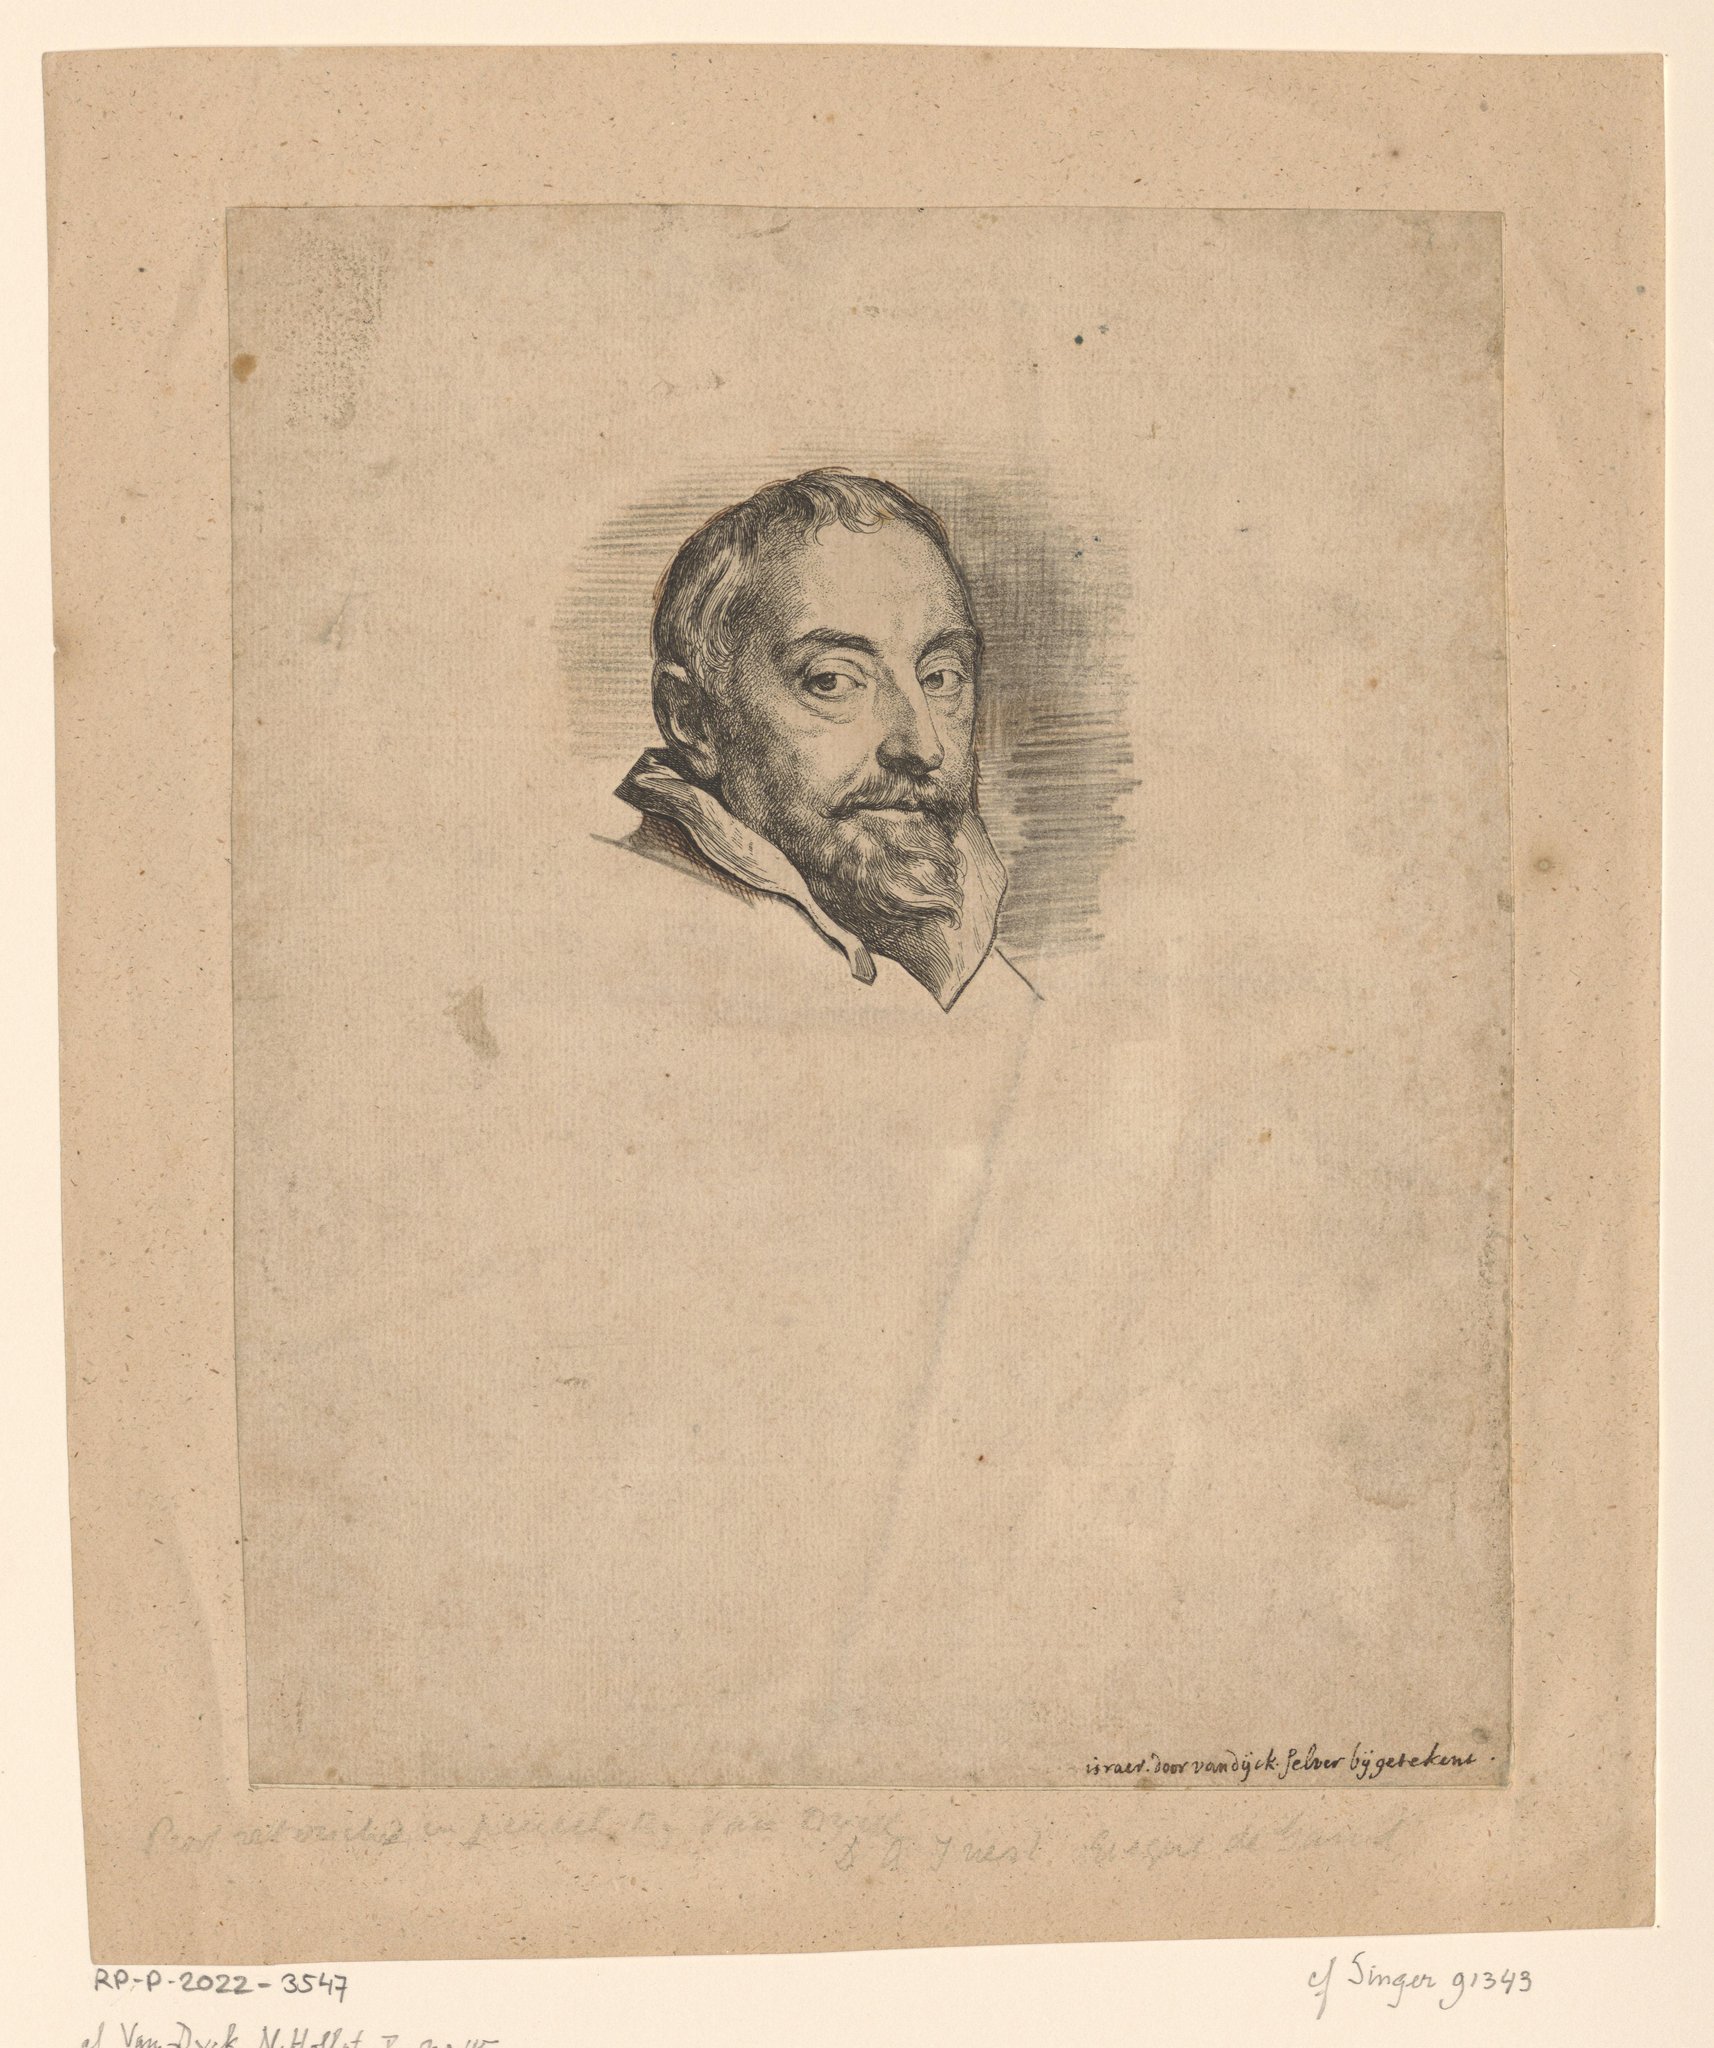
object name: print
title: Portret van Antonius Triest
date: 1632-1645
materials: paper, pencil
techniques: etching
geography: antwerp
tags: ghent, antonius triest, archbishop, bishop, etc. (roman catholic), historical persons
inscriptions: inscription: ‘is raer. door van dijck zelver bijgetekent.’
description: Portret geknipt uit een grotere prent, zie RP-P-1940-1534.